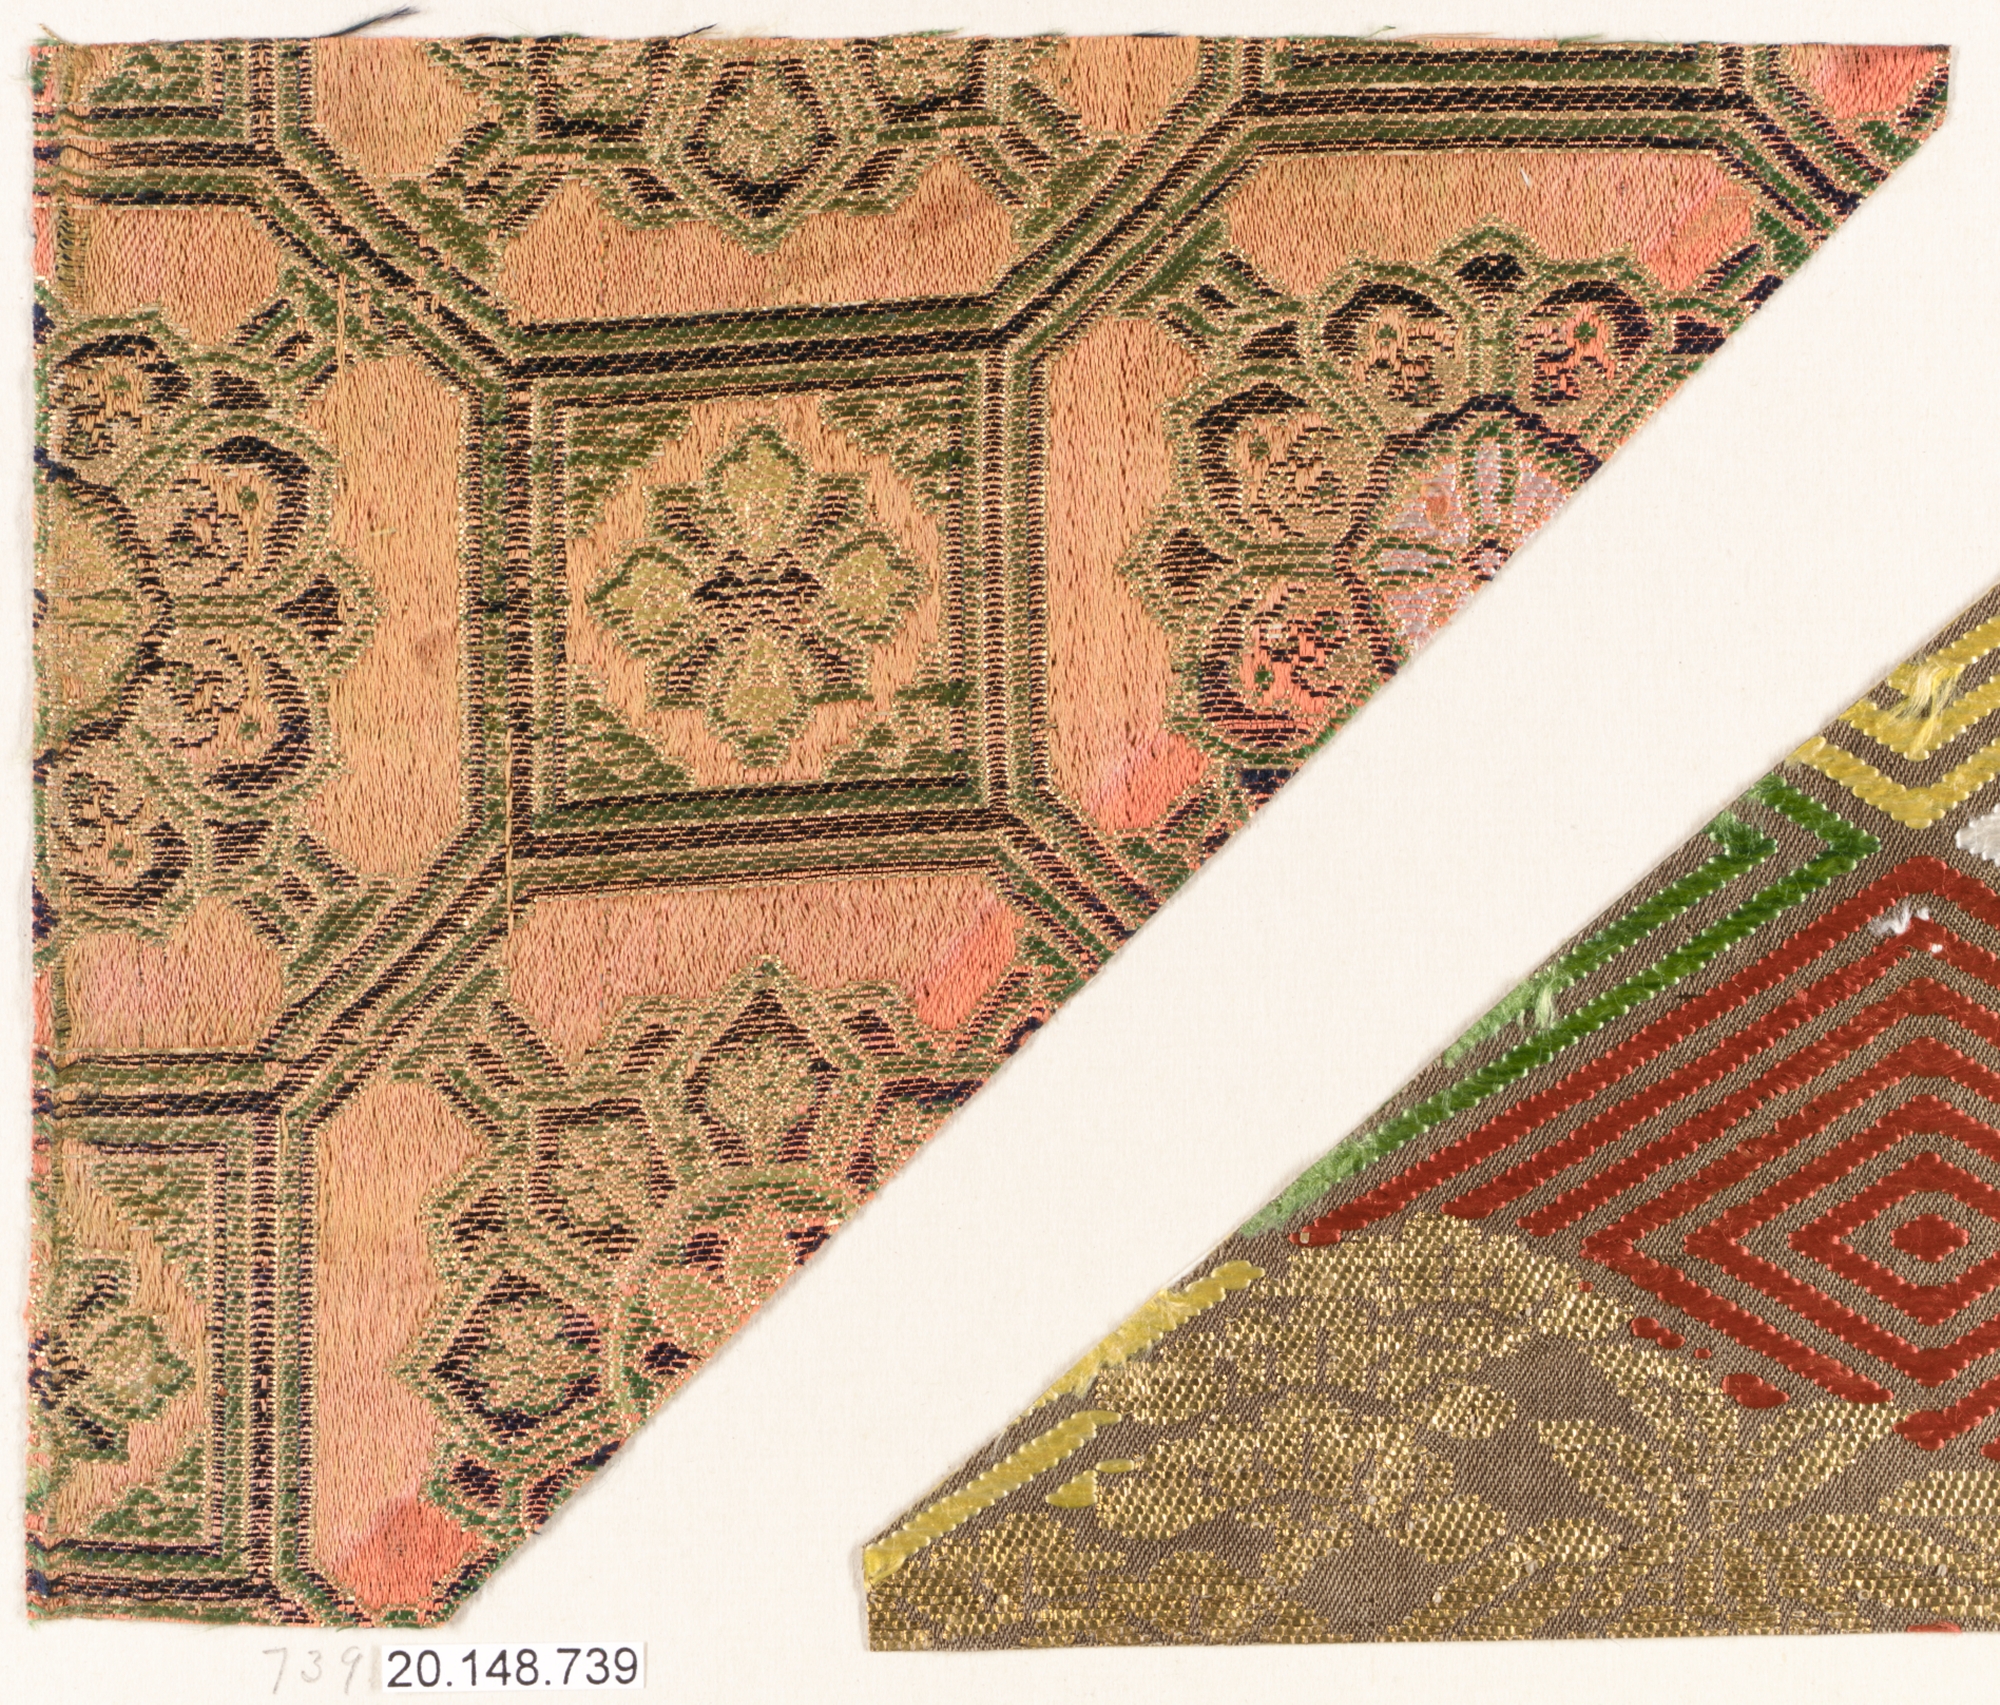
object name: piece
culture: japanese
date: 1601-1700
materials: silk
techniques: compound weave